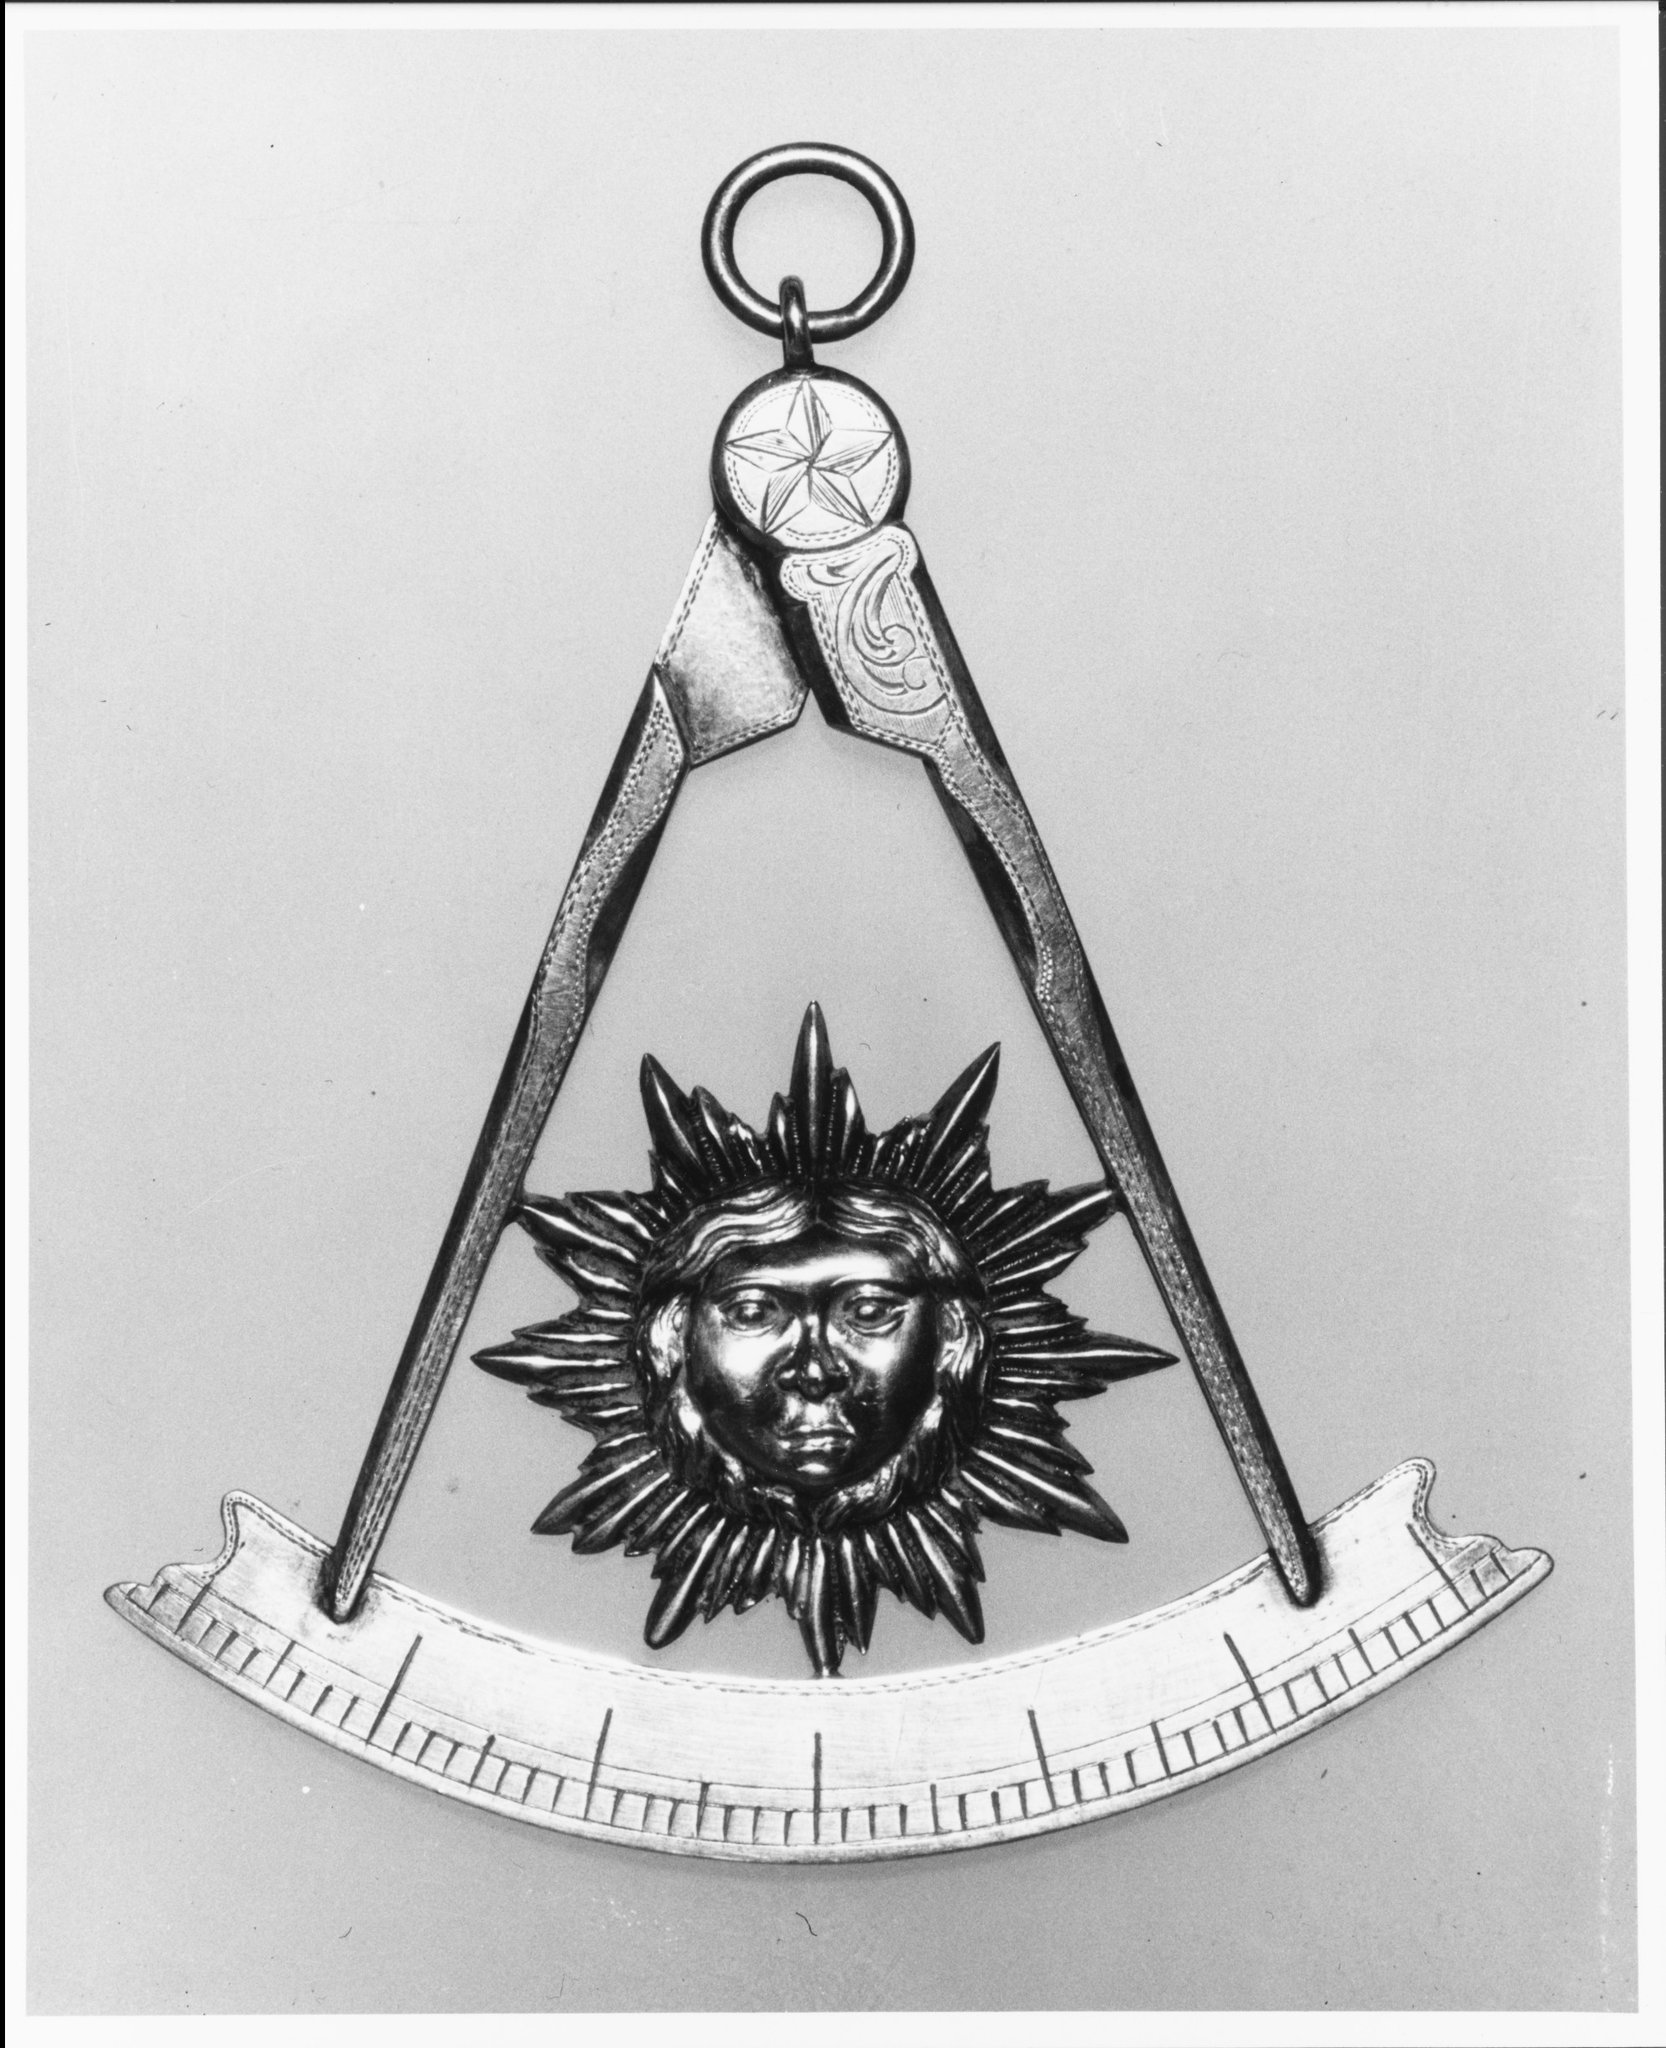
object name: masonic emblem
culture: american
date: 1800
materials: silver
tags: sun,emblems